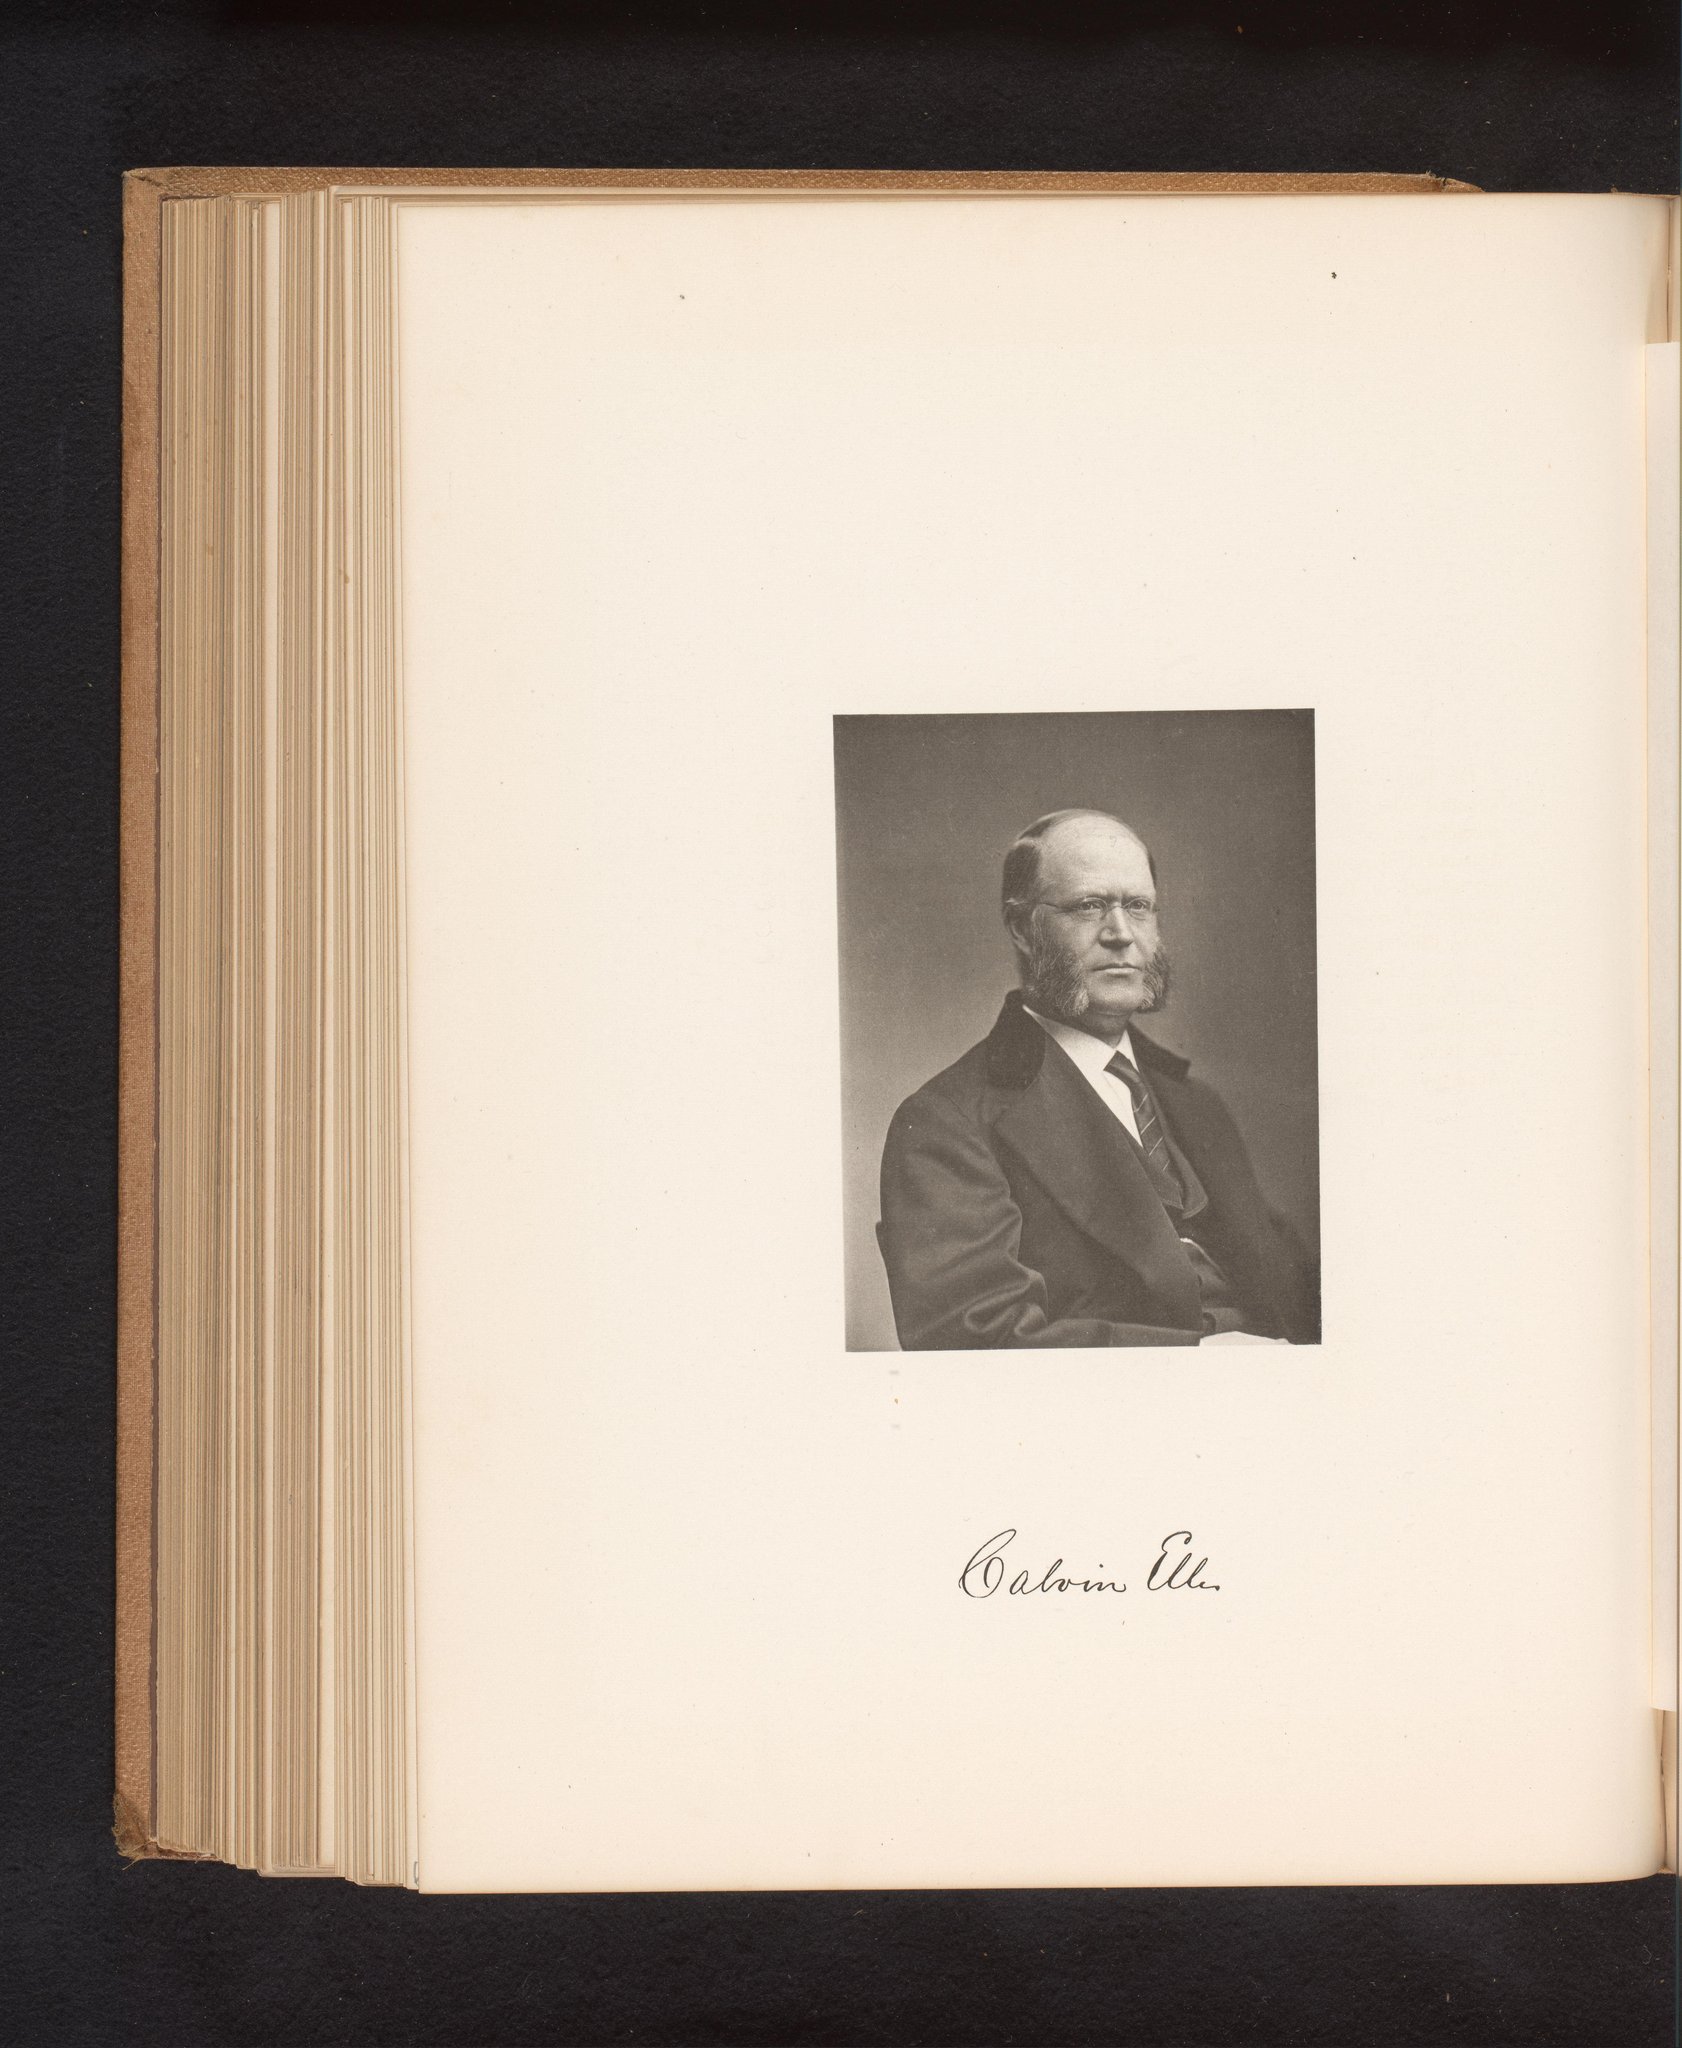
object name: photomechanical print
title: Portret van Calvin Ellis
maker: Anonymous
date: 1870-1875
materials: paper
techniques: photograph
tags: historical persons, physician, doctor, professor